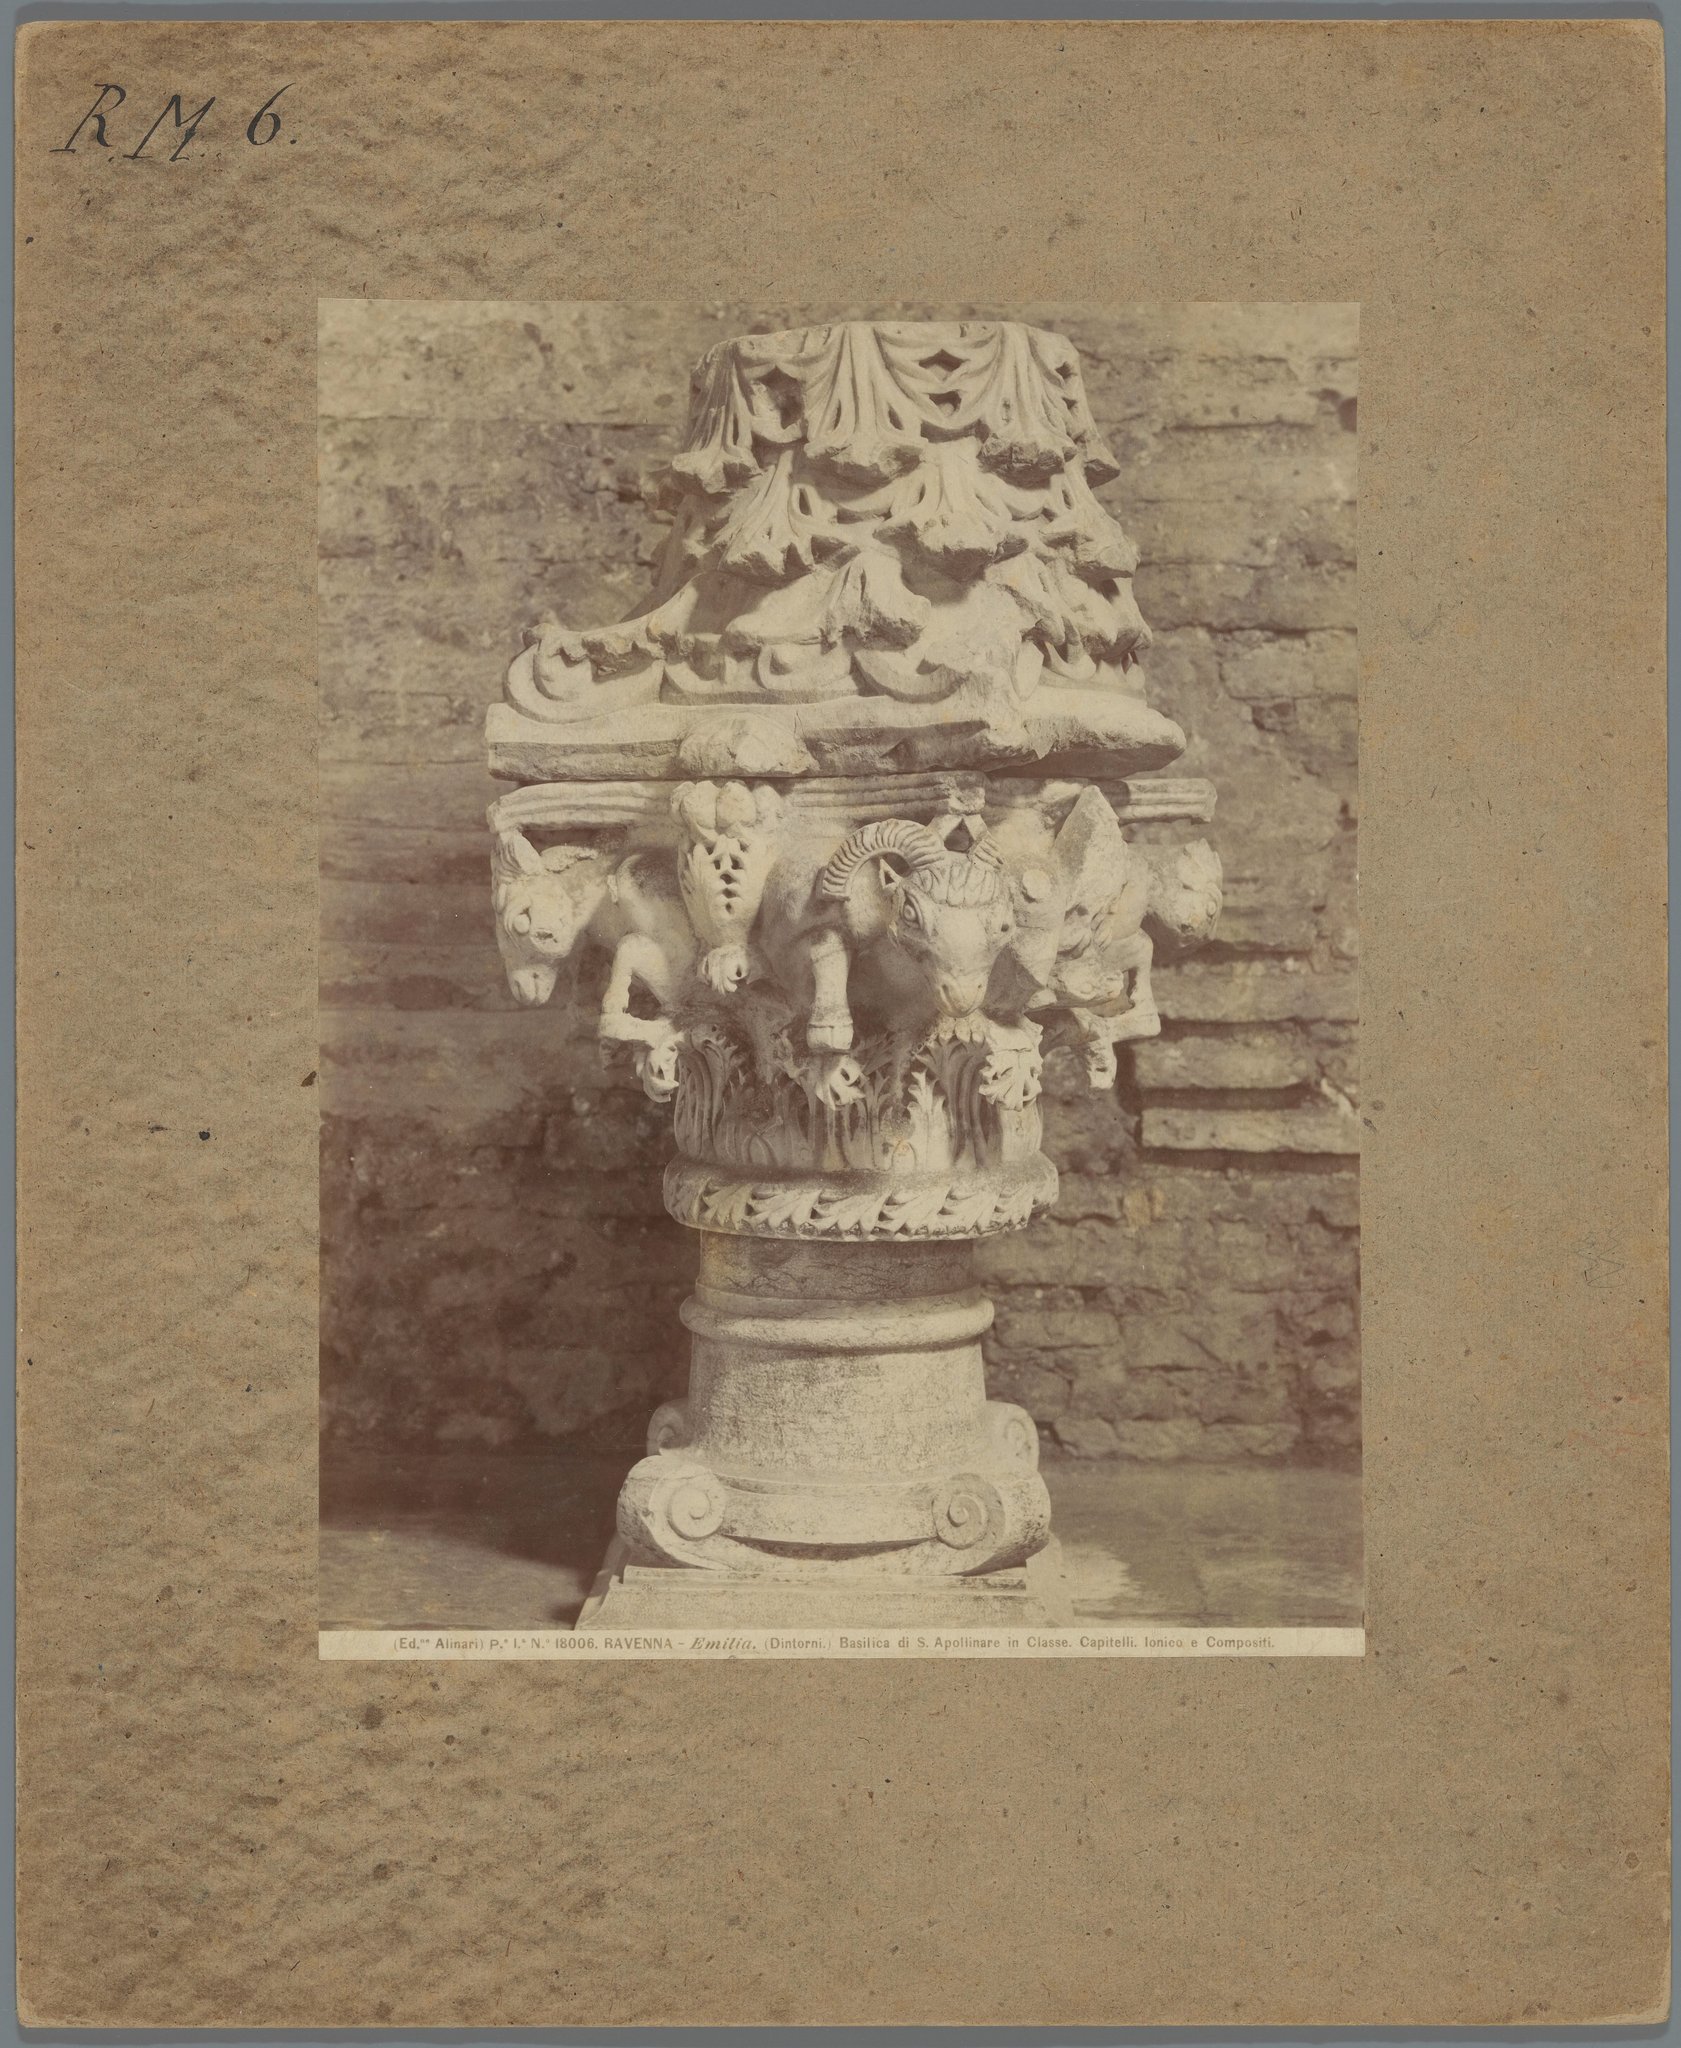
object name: photograph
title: Kapiteel van een zuil in de de basiliek van Sant'Apollinare in Classe te Ravenna, gedecoreerd met rammen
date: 1875-1900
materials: cardboard, photographic support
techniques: albumen print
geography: basiliek van sant'apollinare in classe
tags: ram's head ~ ornament, capital (~ column, pillar)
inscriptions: collector's mark: Lugt 3937, inscription: ‘R.M. 6.’, number: ‘P.e I.a N.o 18006.’